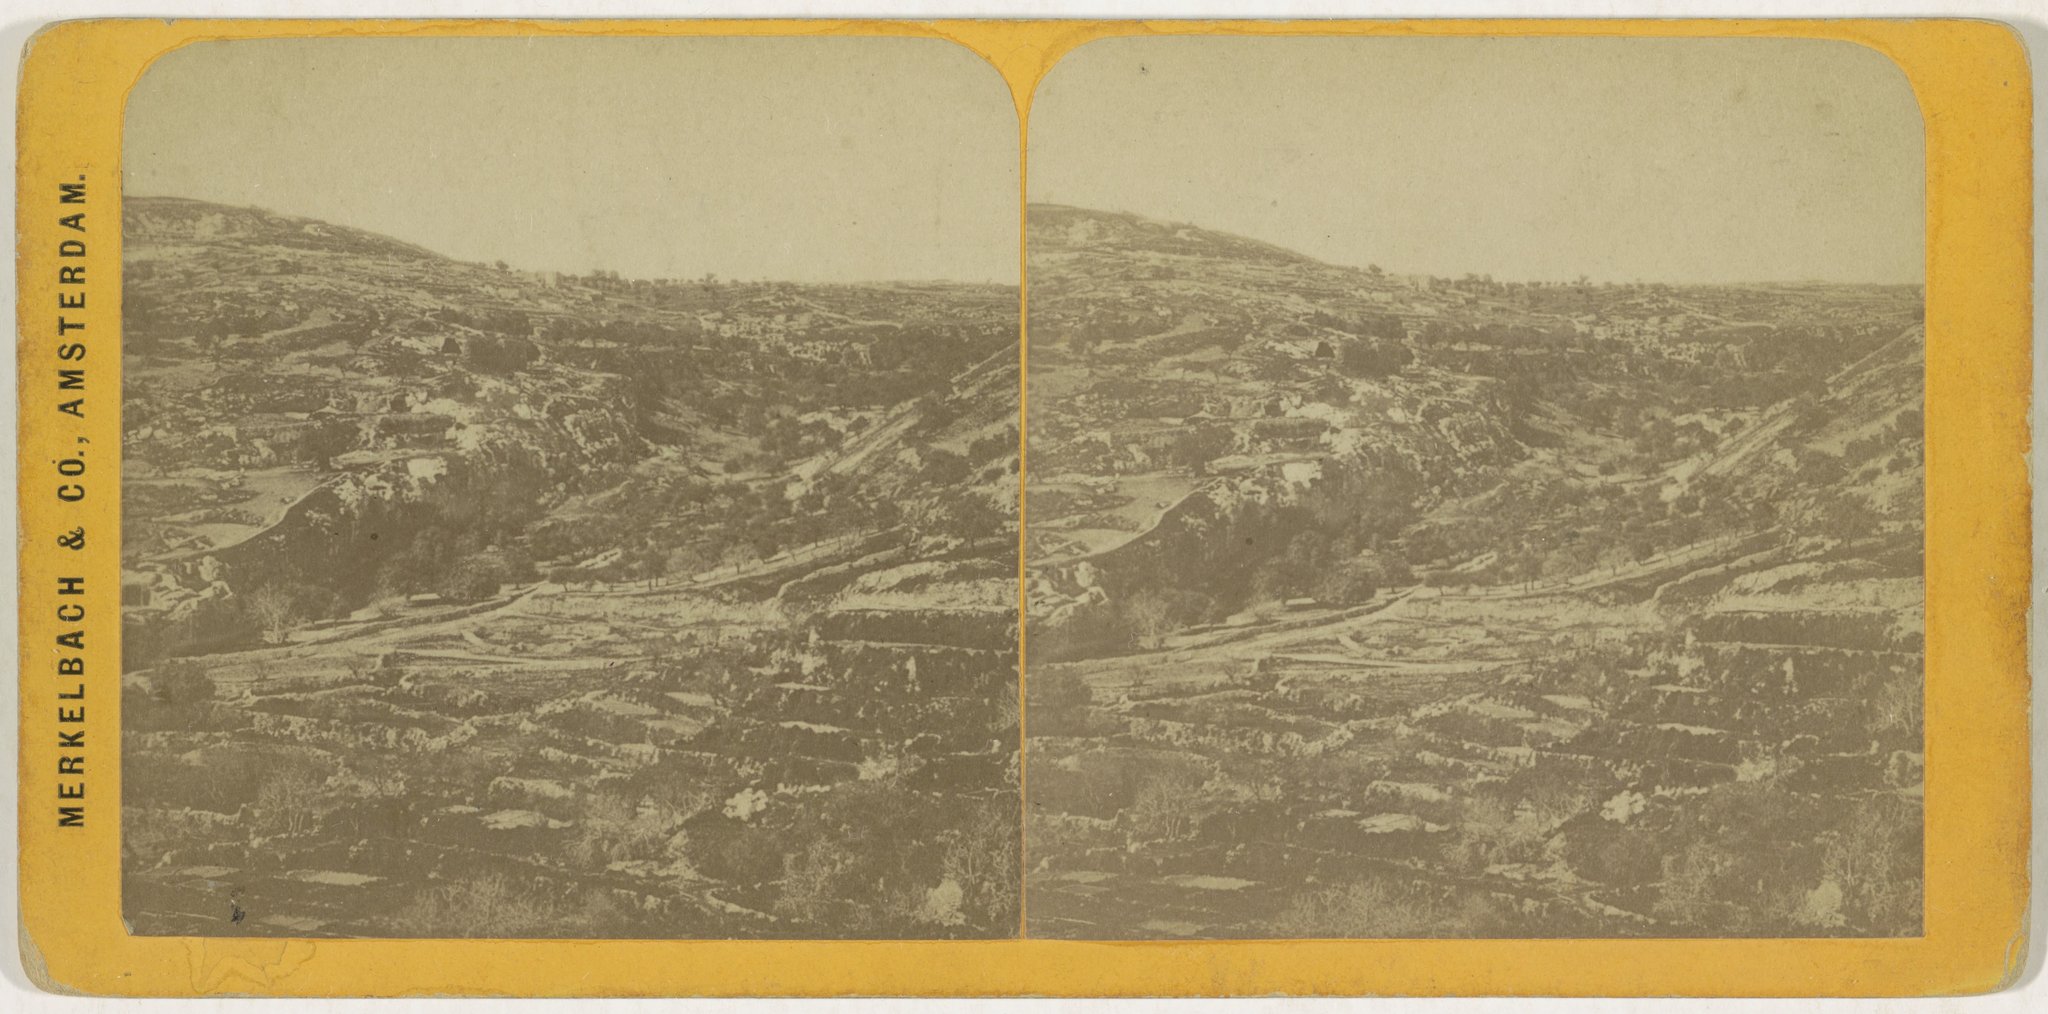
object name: stereograph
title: Dal van Hinnom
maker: Anonymous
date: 1870-1890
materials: cardboard, paper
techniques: albumen print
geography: amsterdam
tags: dale, valley